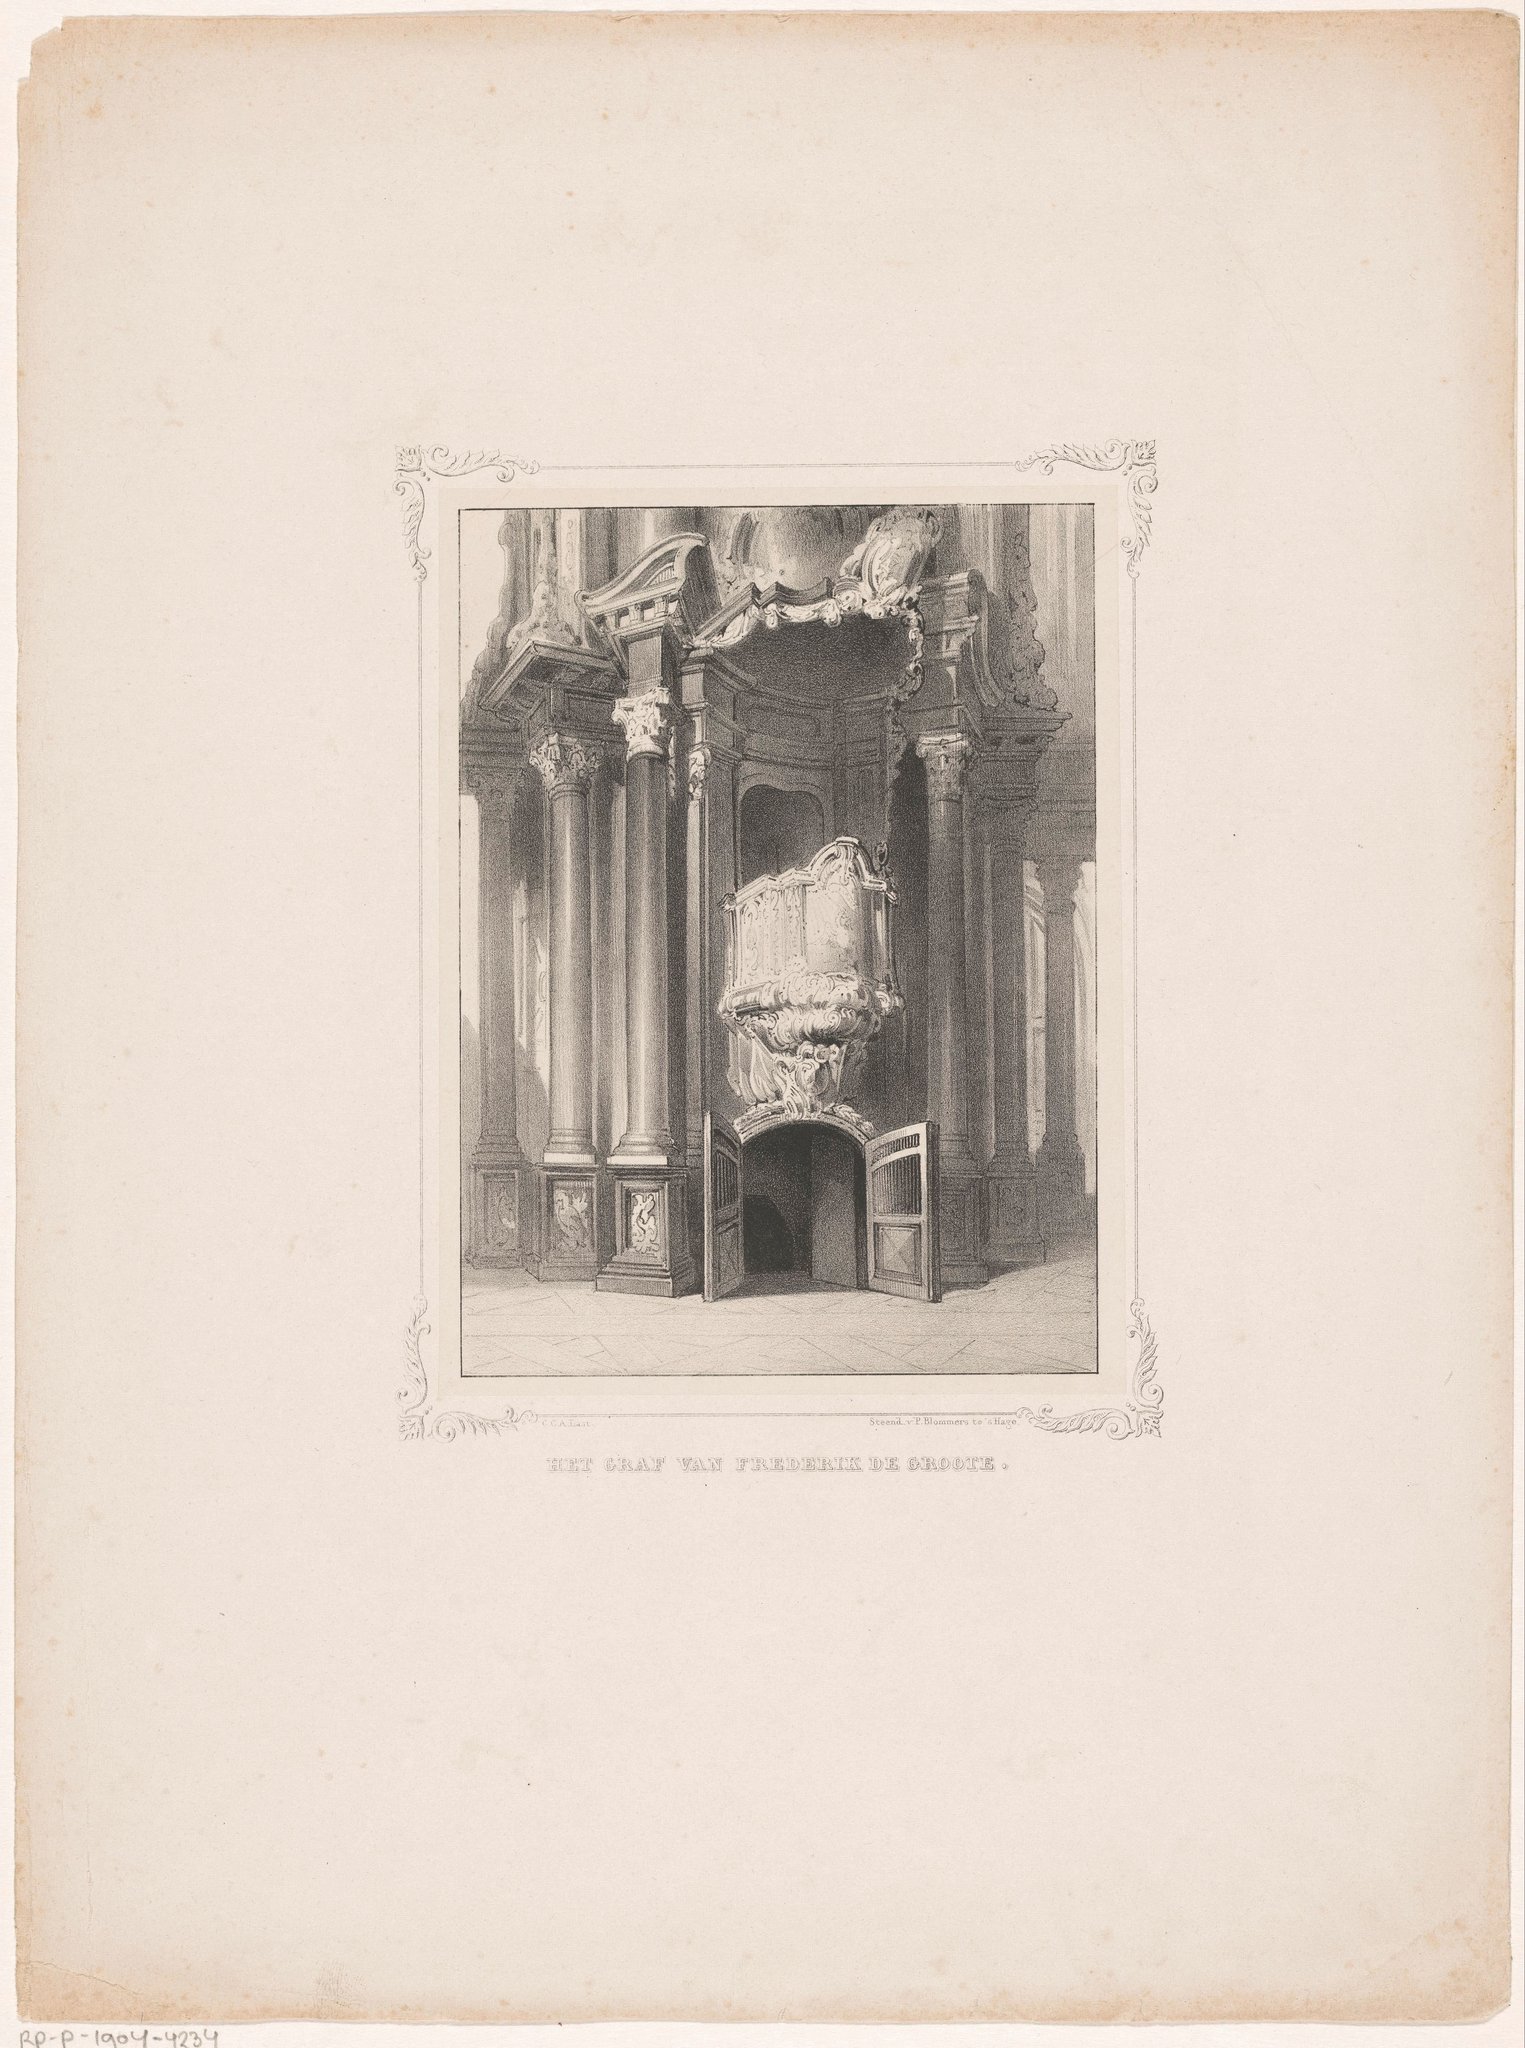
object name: print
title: Het graf van Frederik de Groote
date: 1842-1887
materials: paper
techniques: lithograph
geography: the hague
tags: berlin, frederick ii (king of prussia), interior of church, pulpit, ambo, chancel, parts of church interior (crypt)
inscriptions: collector's mark: Lugt 2228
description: Het lichaam van Frederik II van Pruisen is later meerder malen verplaatst.